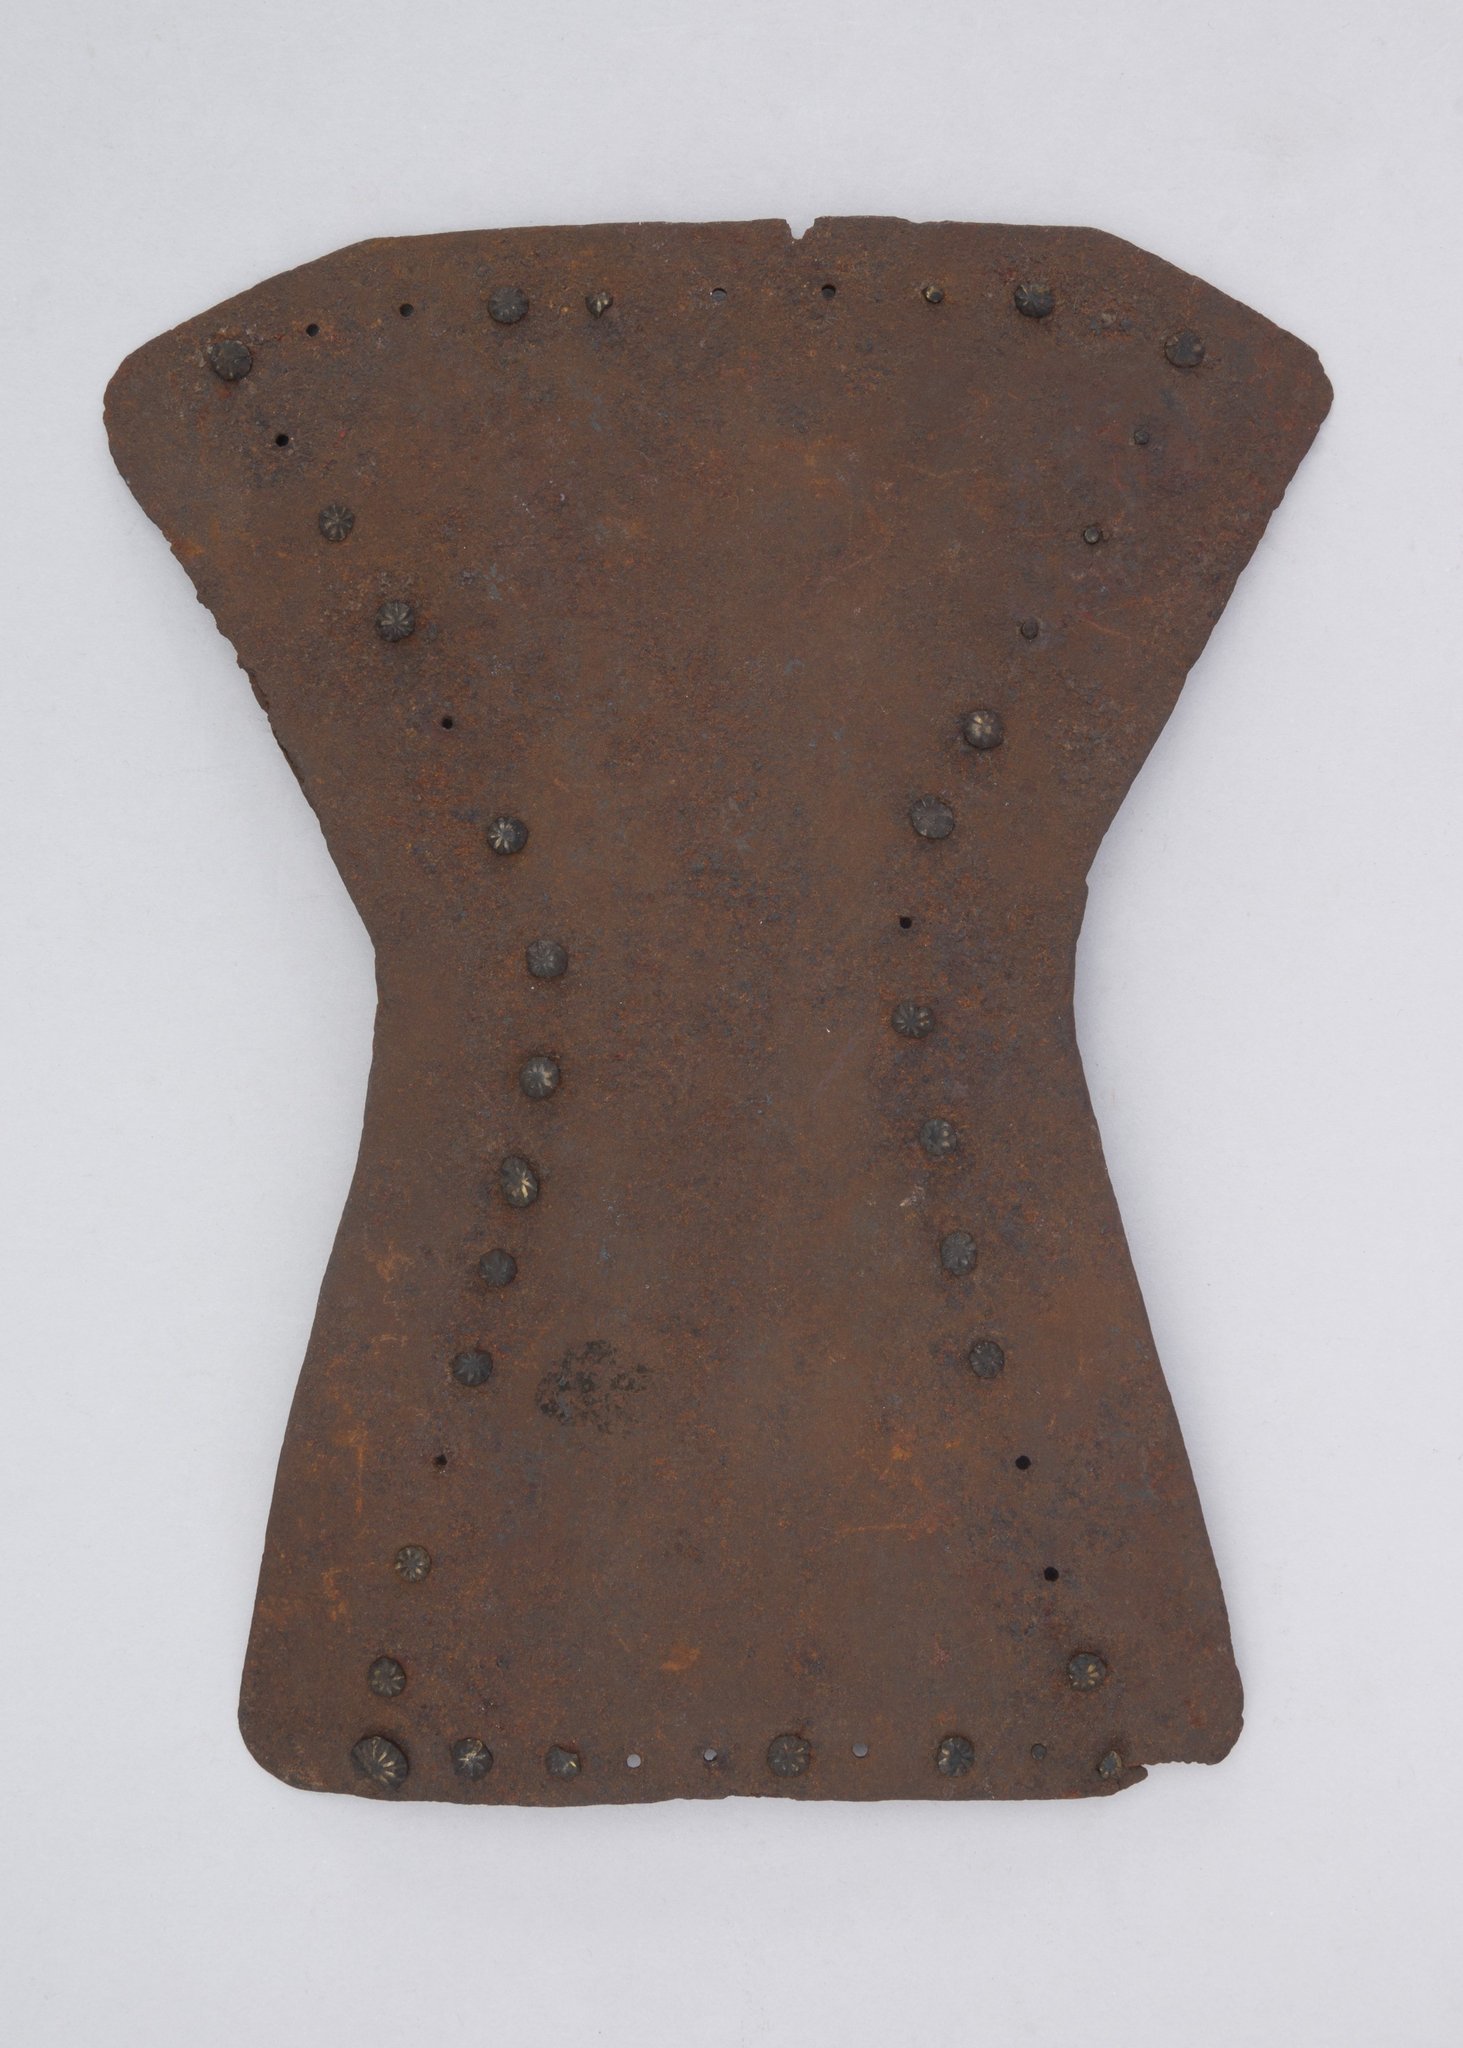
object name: brigandine plate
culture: italian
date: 1350-1450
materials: copper alloy, metal alloy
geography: italy